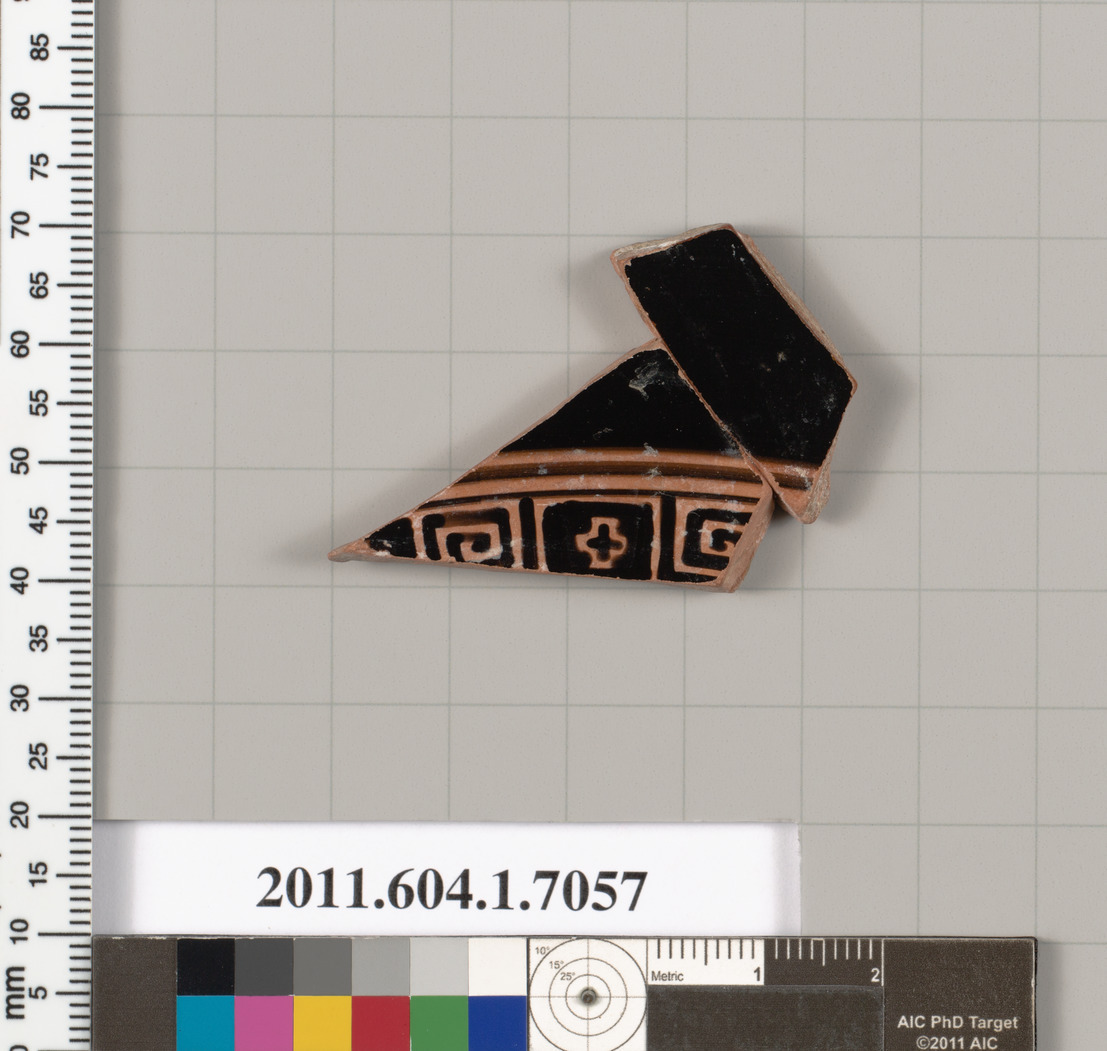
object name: kylix fragment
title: Terracotta fragment of a kylix (drinking cup)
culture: greek, attic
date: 500-480 BCE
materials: terracotta